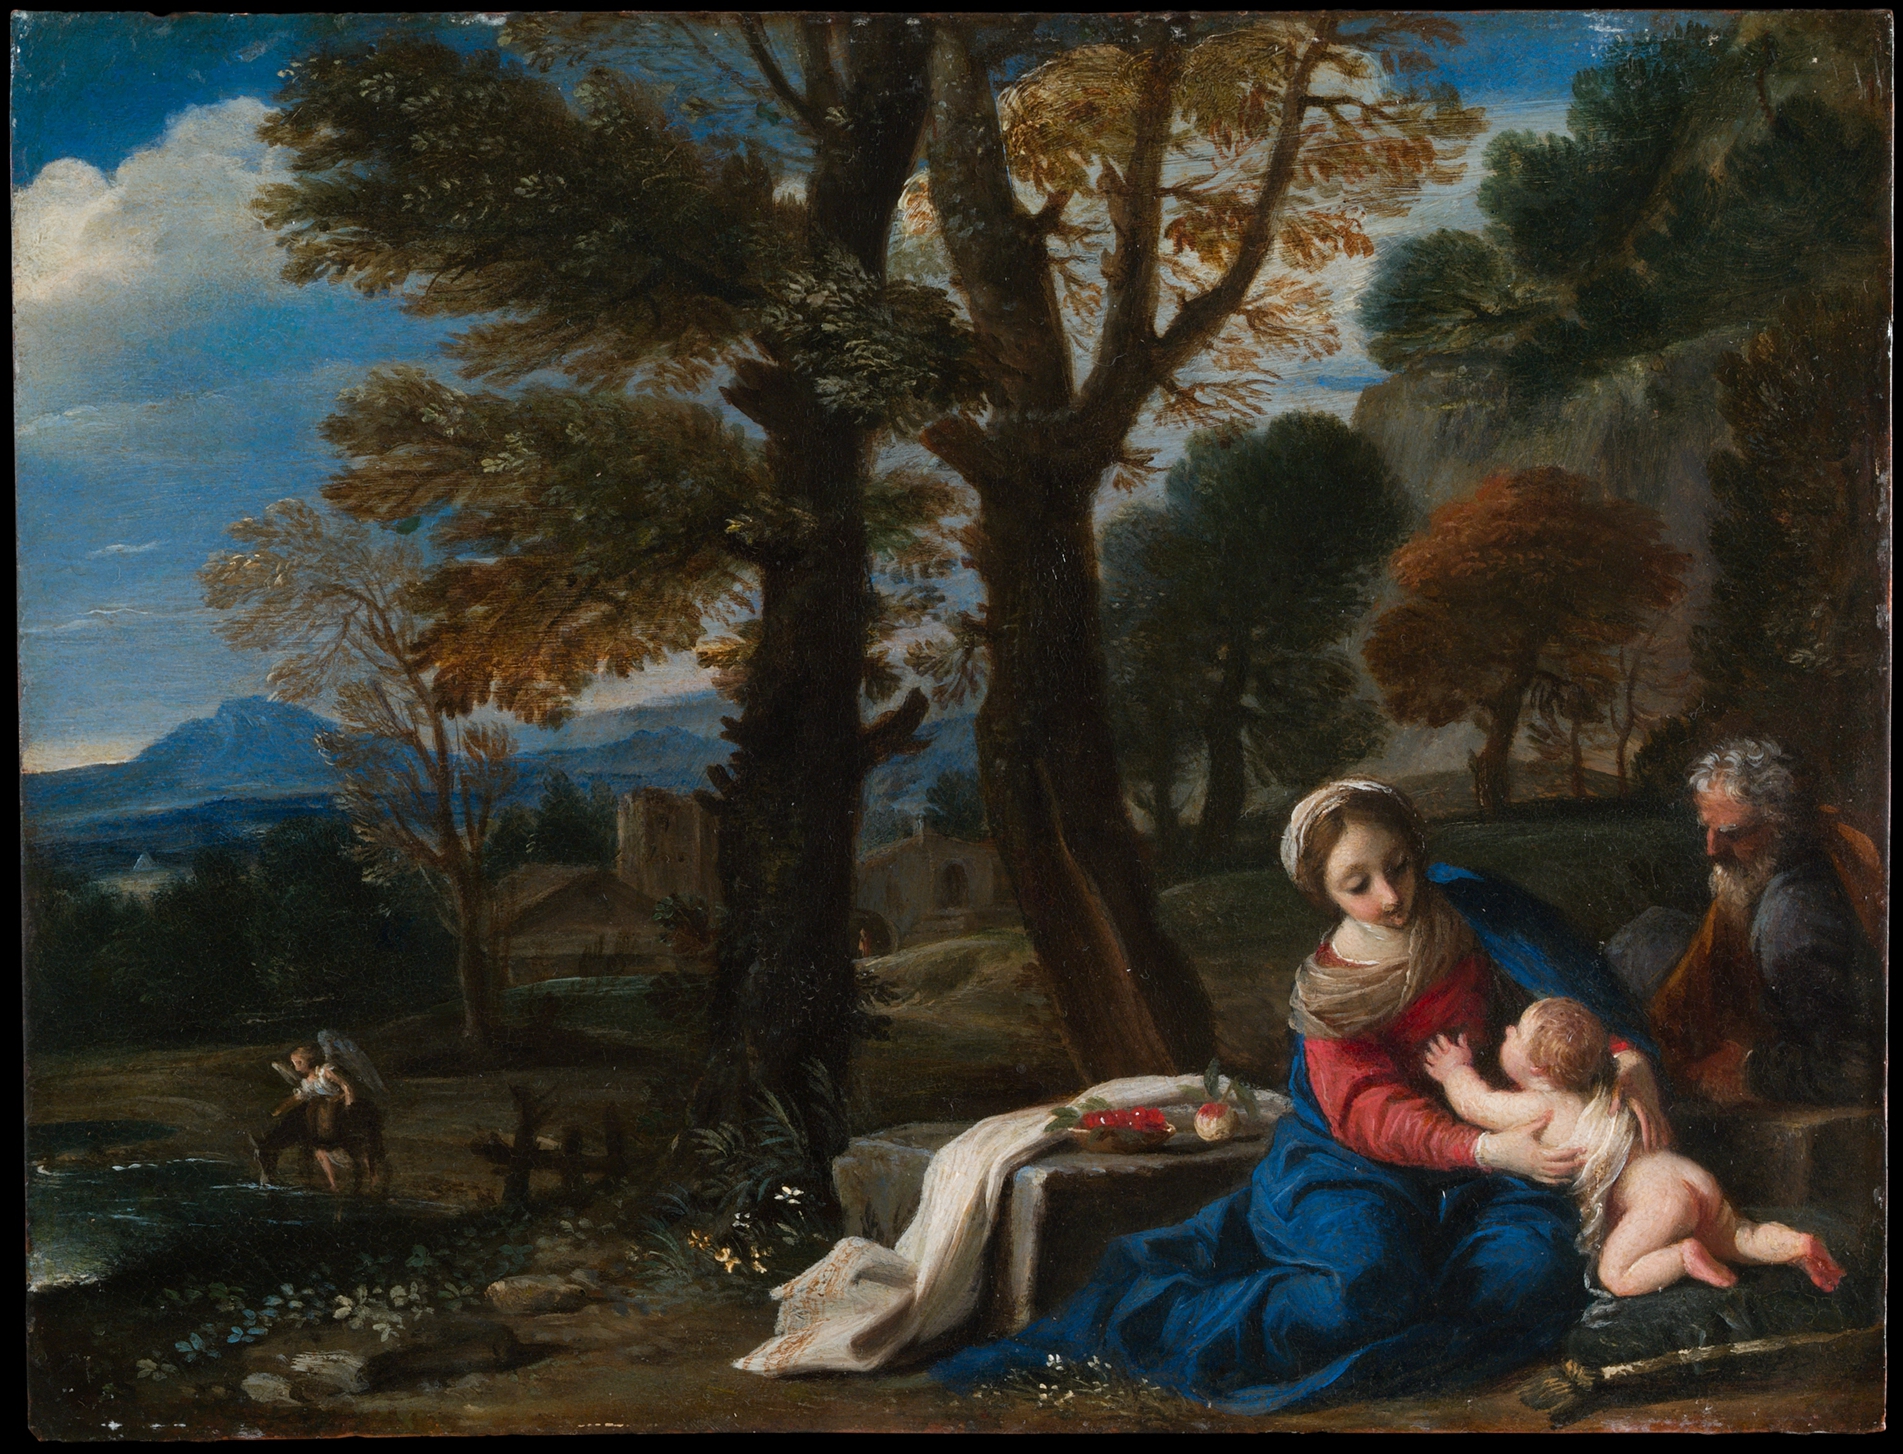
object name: painting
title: The Rest on the Flight into Egypt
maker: pier francesco mola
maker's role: artist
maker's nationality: italian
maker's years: 1612-1666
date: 1641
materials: copper, oil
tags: donkeys,angels,holy family